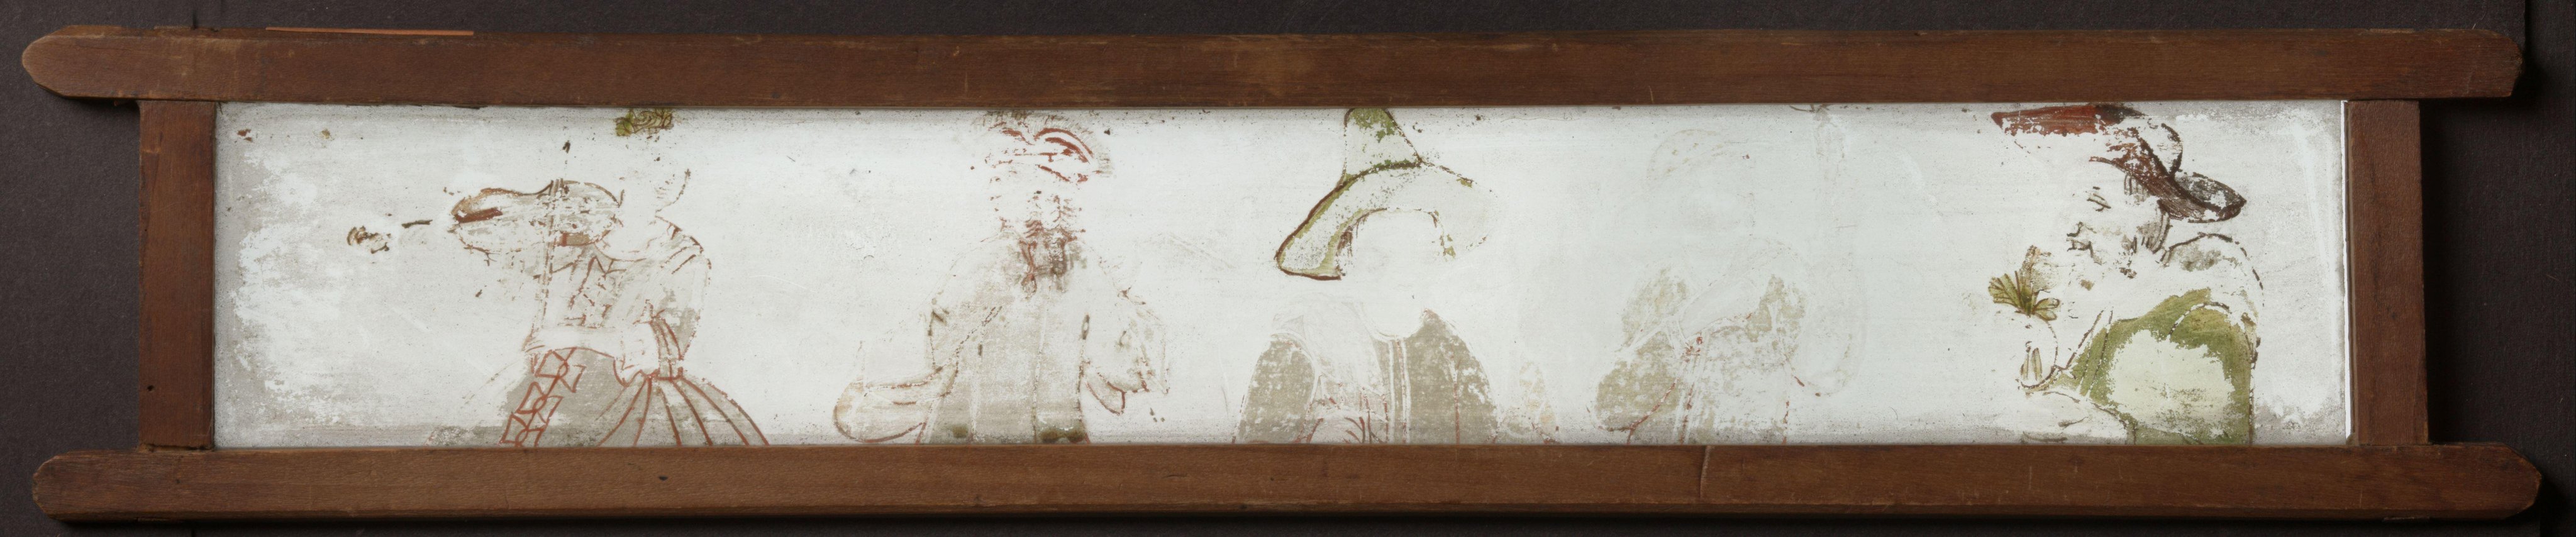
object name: lantern slide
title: Vijf figuurtjes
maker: Anonymous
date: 1700-1750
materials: glass, wood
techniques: painted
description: Houten frame met glasplaat, gebruikt voor toverlantaarn. Vijf figuurtjes. Rechts is een vioolspelende vrouw zichtbaar.